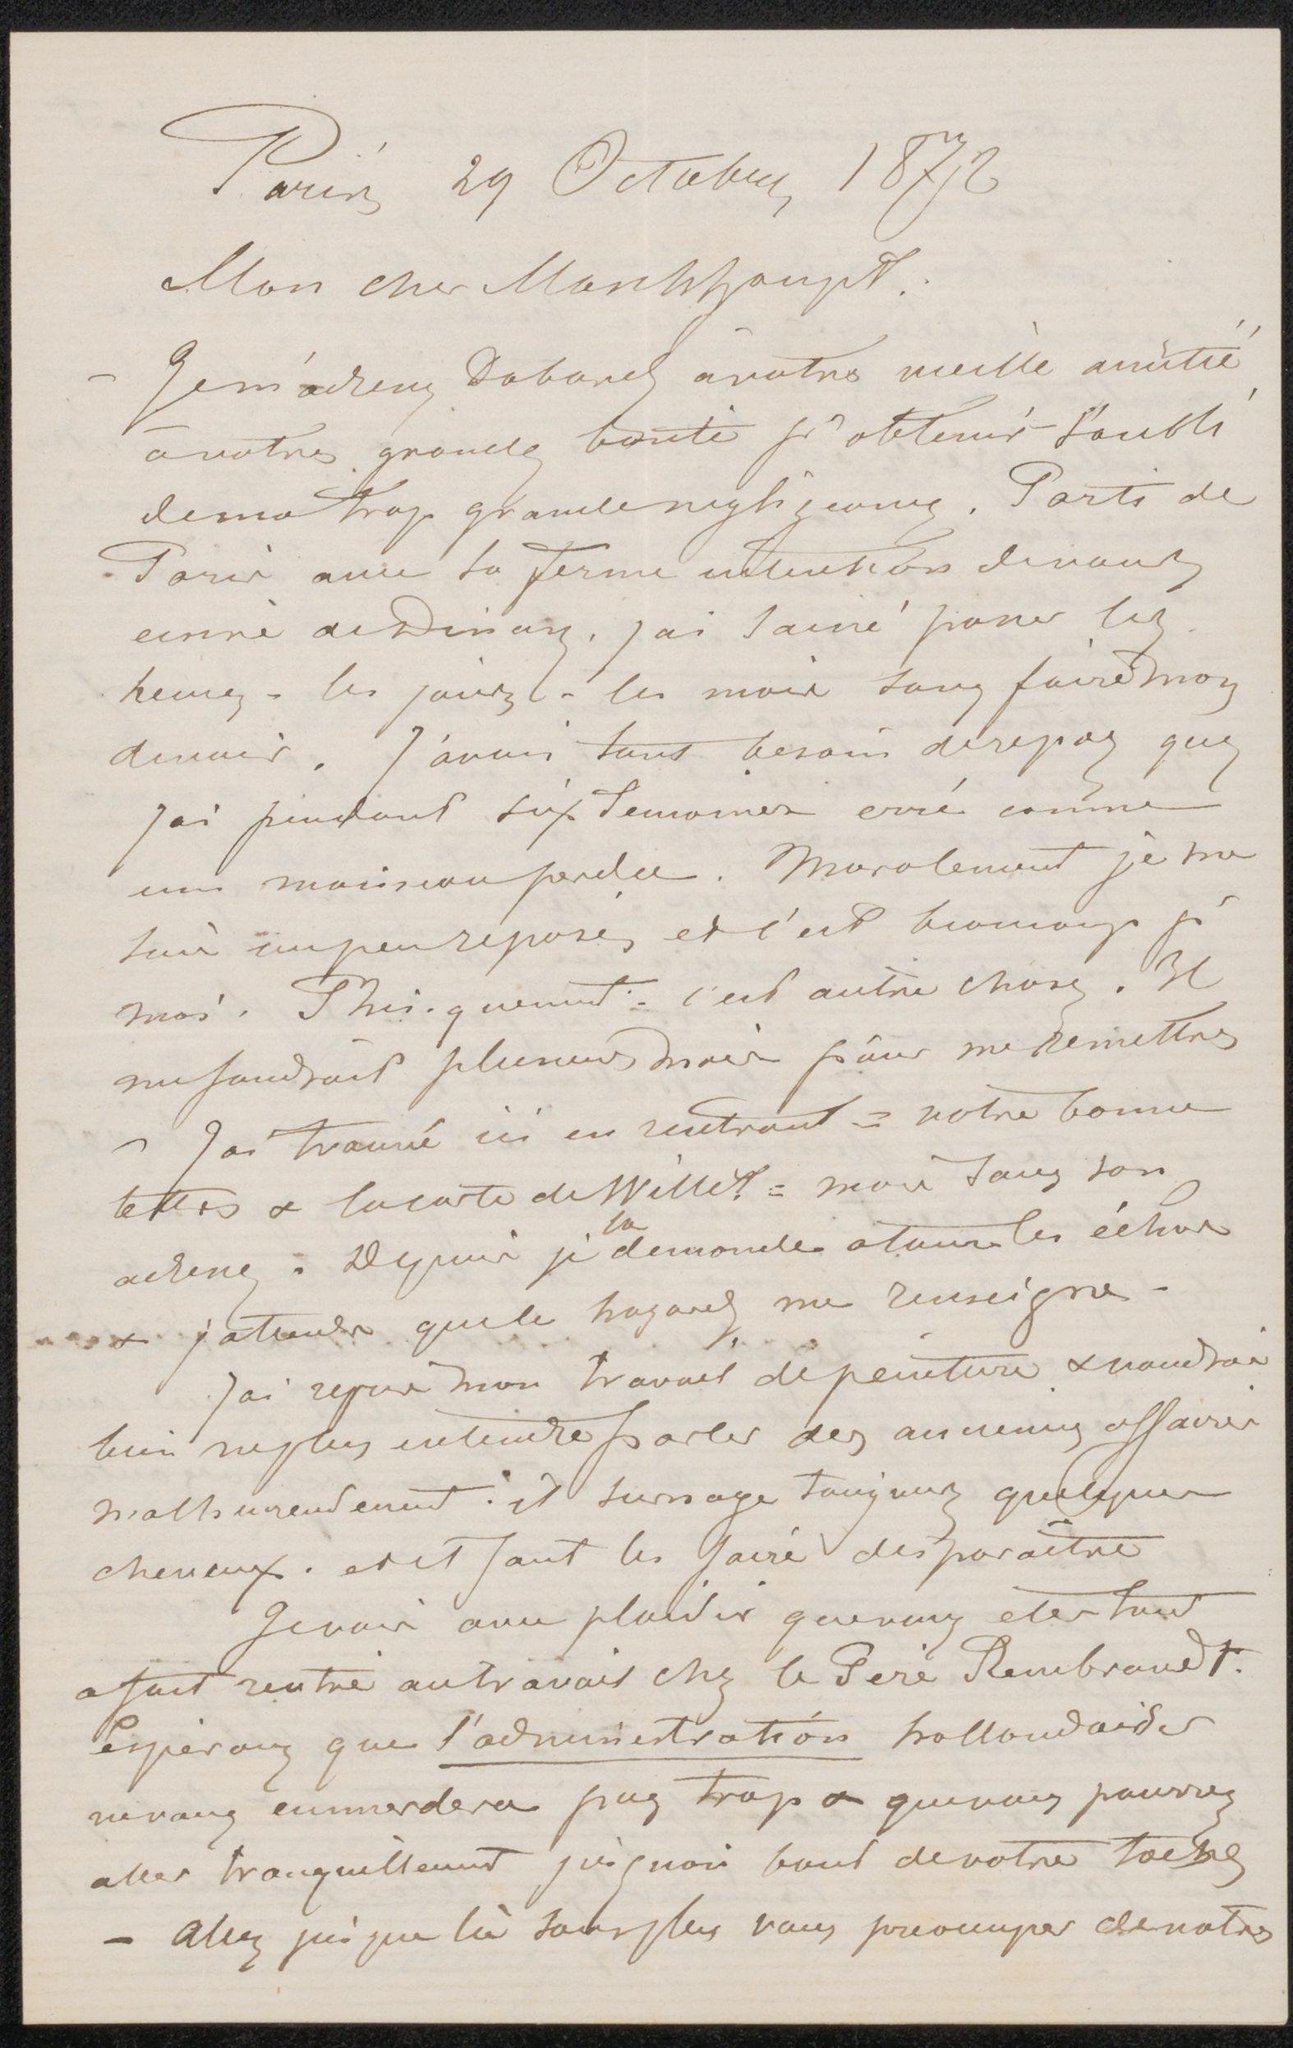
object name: letter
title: Brief aan Jan Hendrik Maschaupt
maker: adolphe mouilleron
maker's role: draughtsman, print maker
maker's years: 1820-1881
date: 1872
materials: ink, paper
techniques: pen, writing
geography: paris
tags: paris, andrzej graaf mniszech, jan hendrik maschaupt, leiden, amsterdam, painter, print maker, draughtsman, rembrandt van rijn, the graphic arts, painting (including book-illumination, miniature-painting)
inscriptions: collector's mark: ‘RPK’